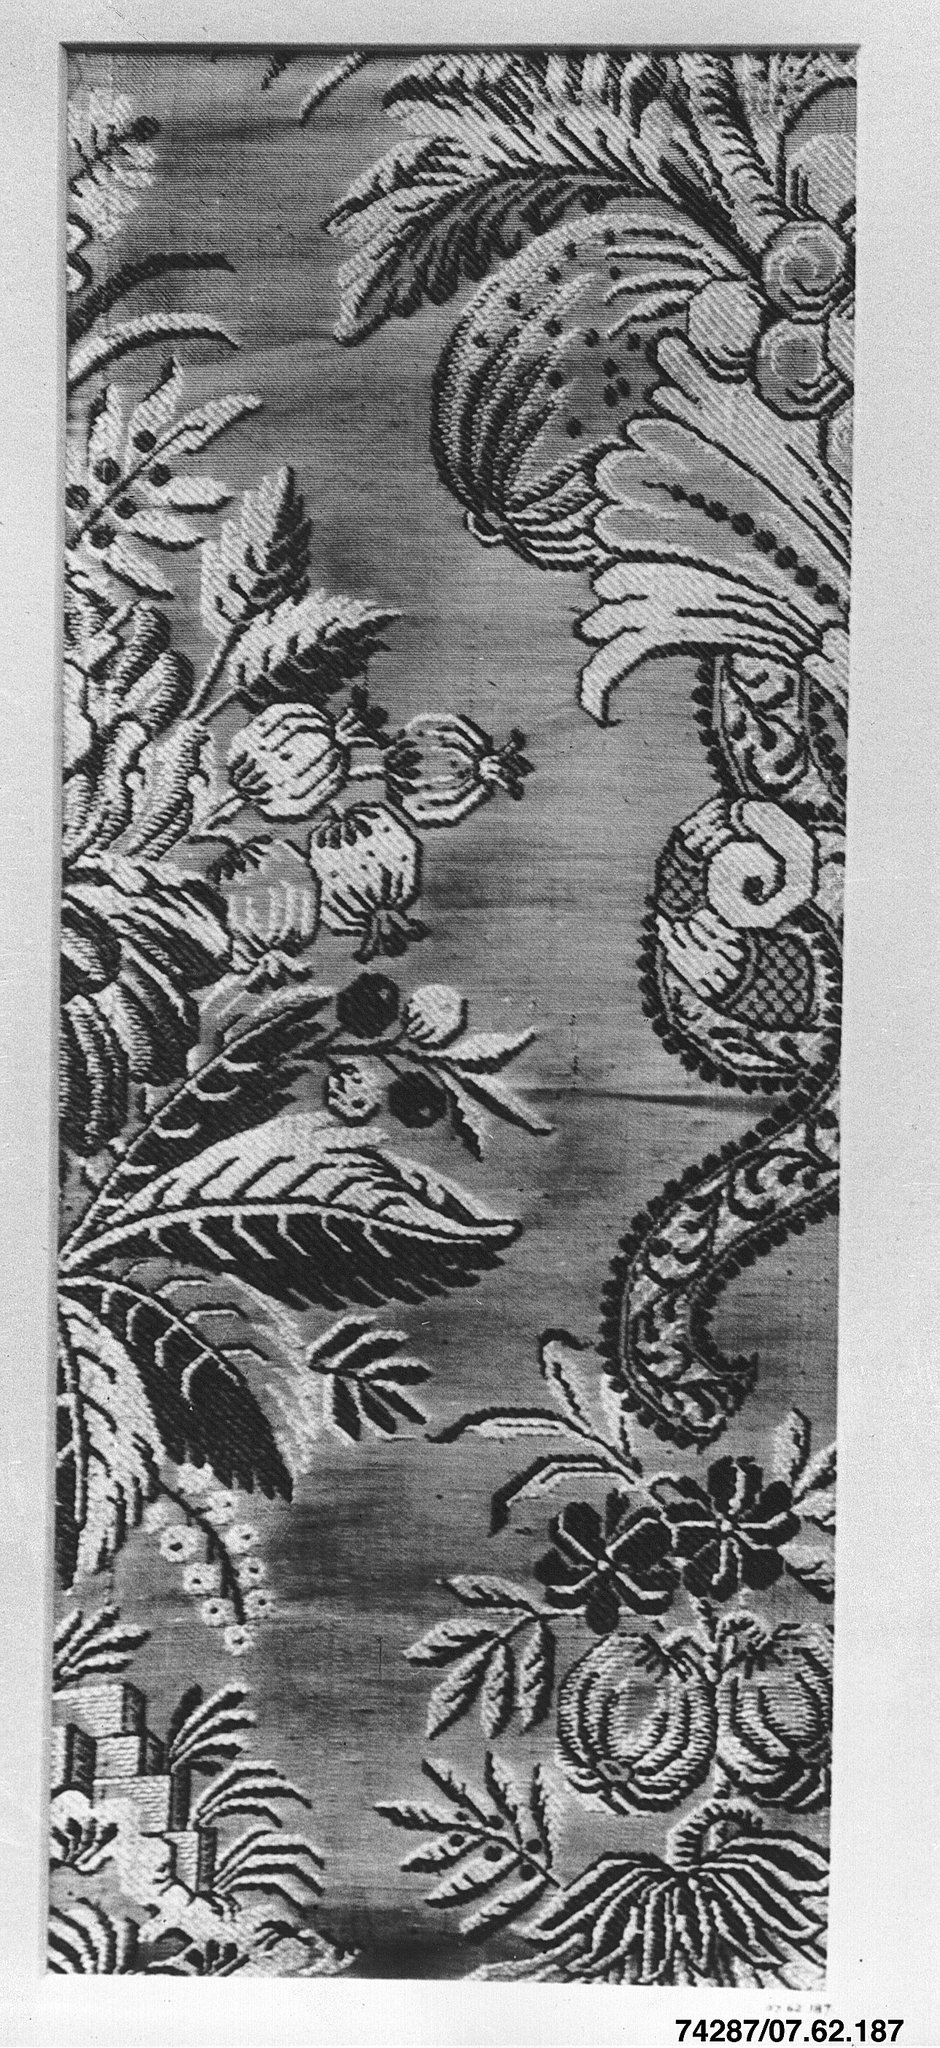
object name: piece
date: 1725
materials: silk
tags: flowers,leaves